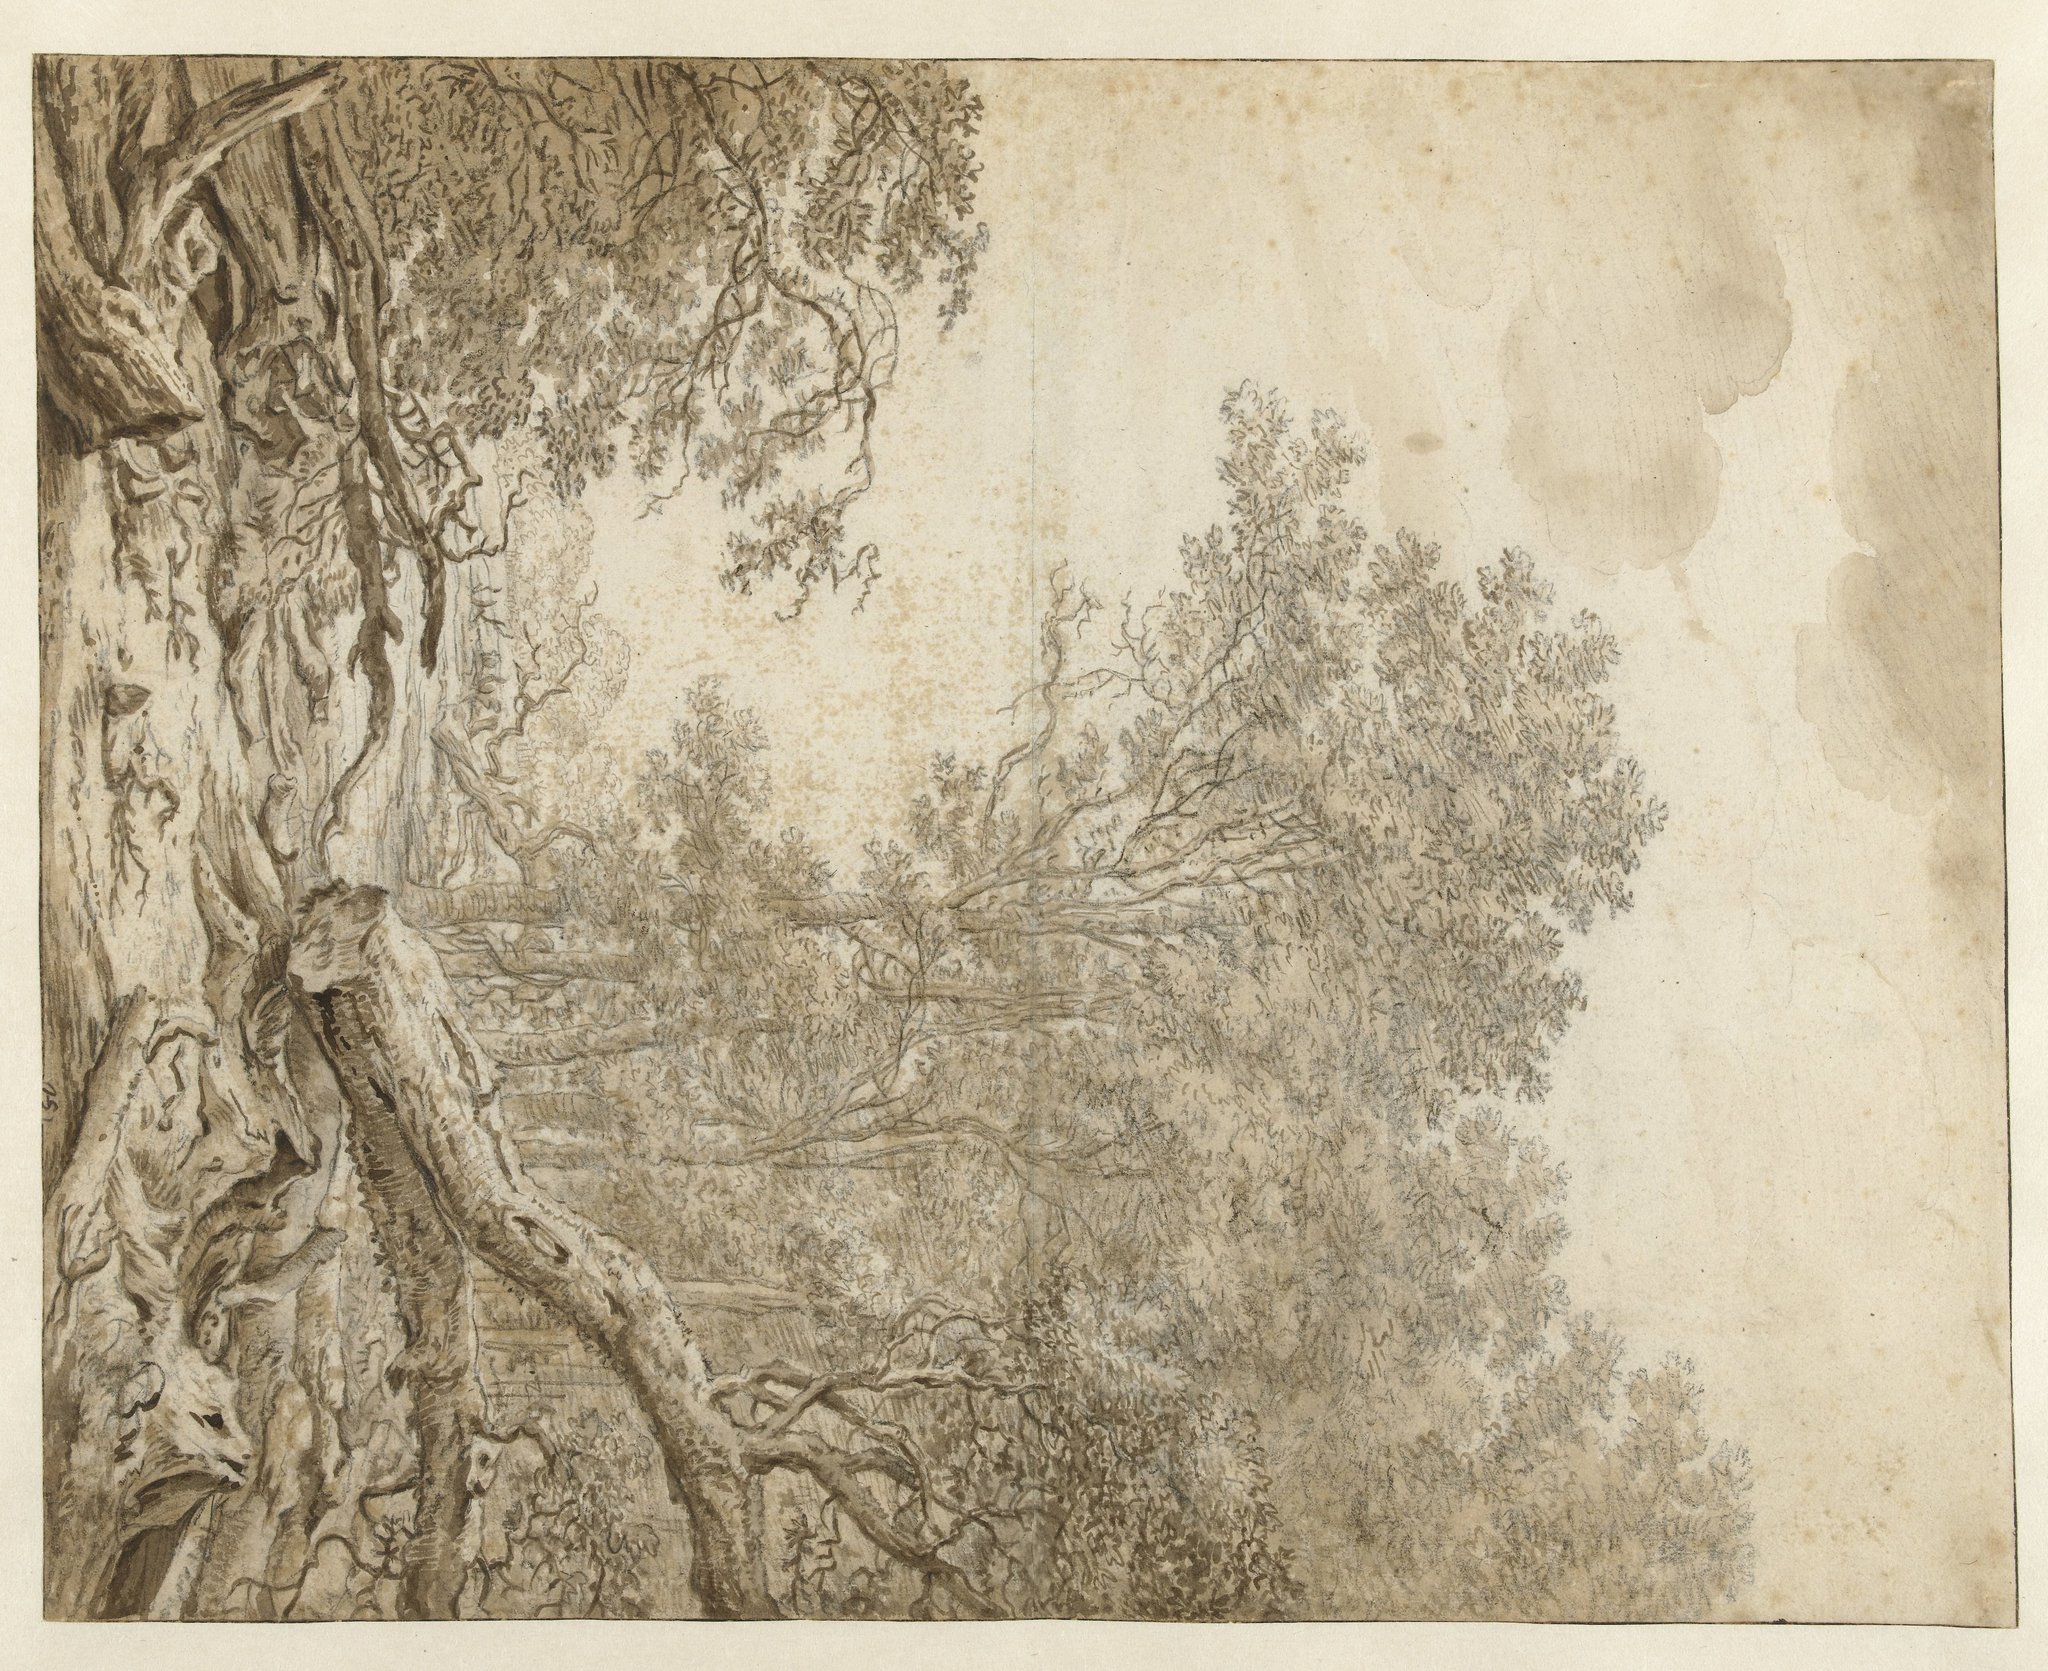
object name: drawing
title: Hoog Soerensche Bosschen bij Apeldoorn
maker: herman saftleven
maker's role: draughtsman, painter, print maker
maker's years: 1609-1685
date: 1640-1649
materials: chalk, paper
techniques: brush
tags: forest, wood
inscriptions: : ‘In het Soerense bos’